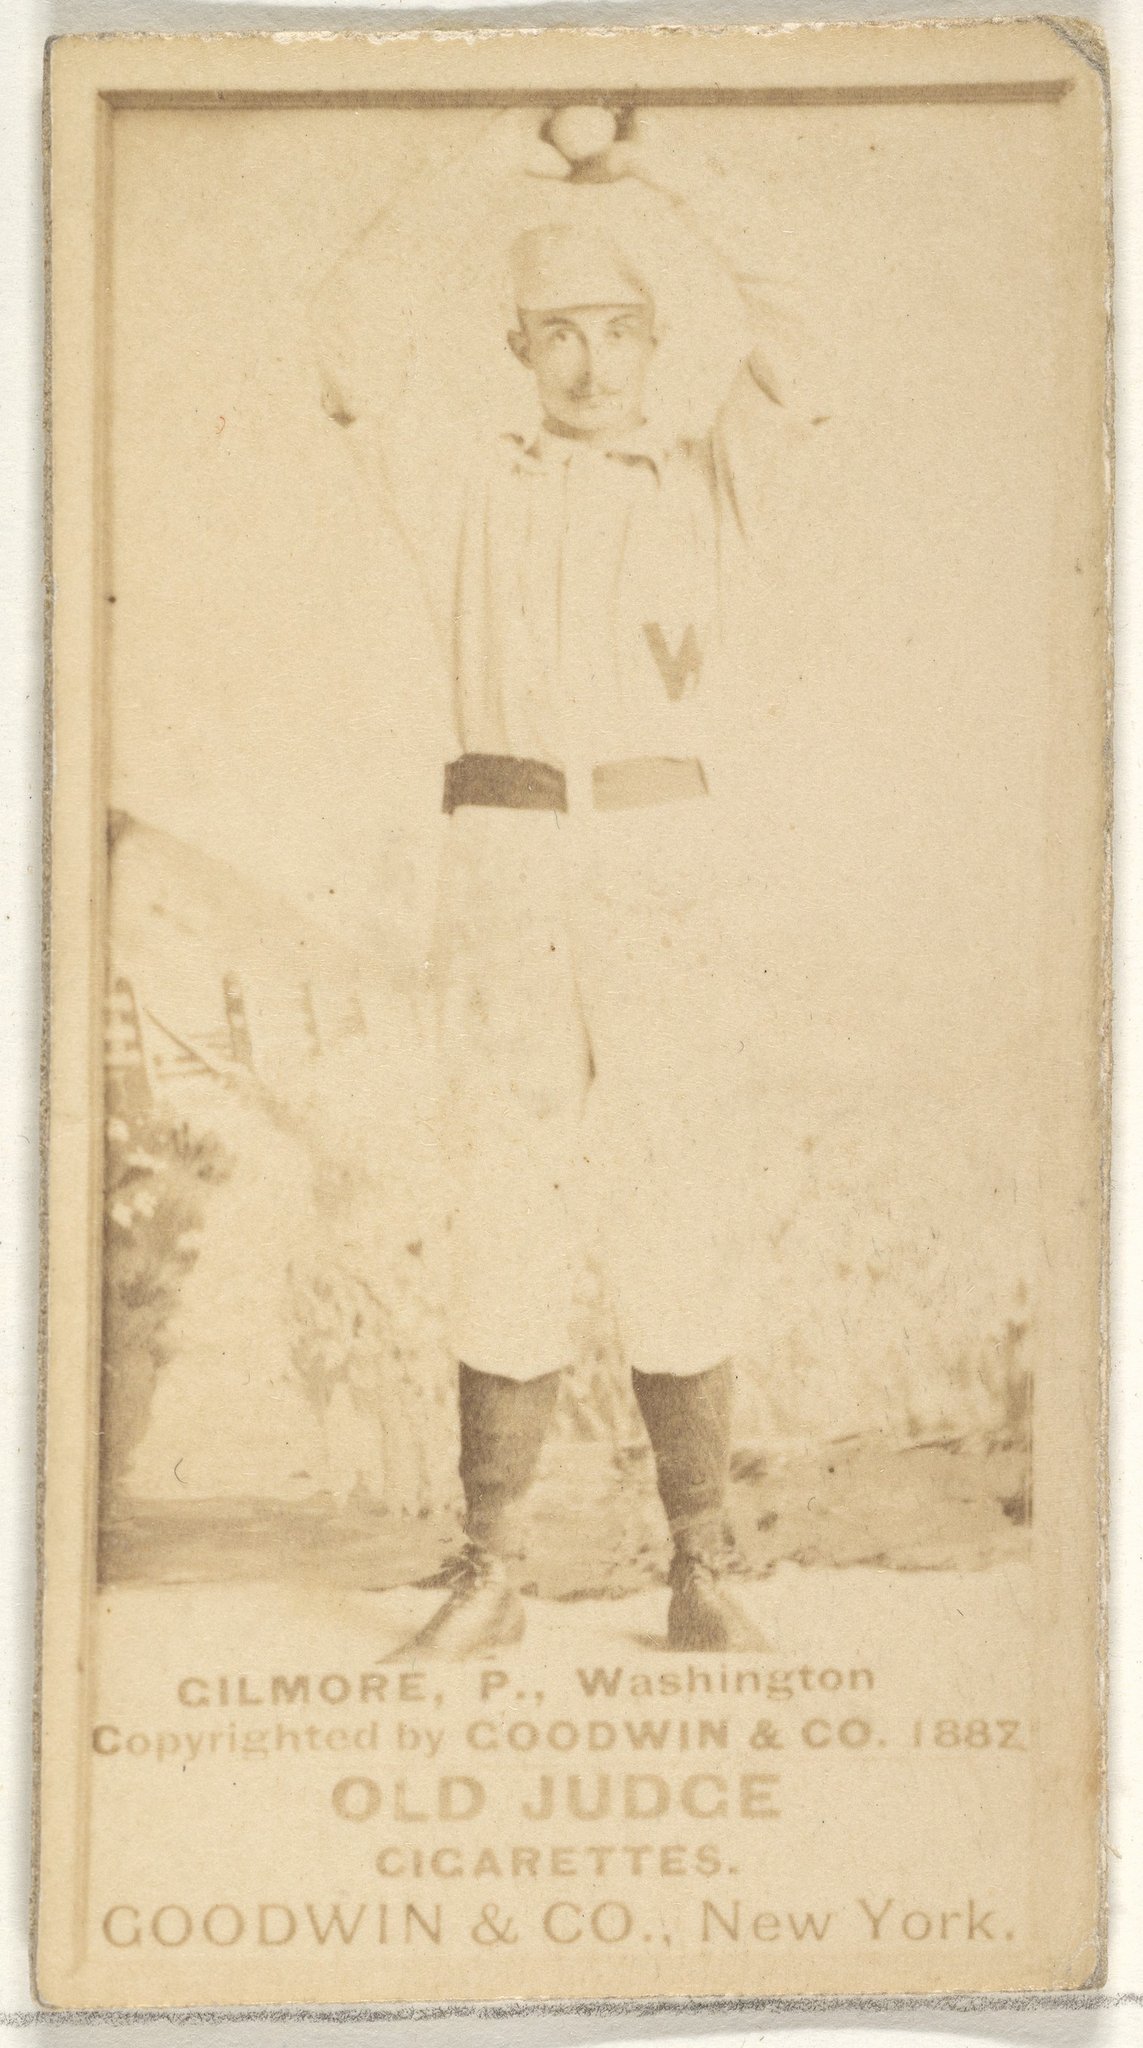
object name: baseball card, photograph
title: Frank T. Gilmore, Pitcher, Washington Nationals, from the Old Judge series (N172) for Old Judge Cigarettes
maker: goodwin & company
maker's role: publisher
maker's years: 1850-1950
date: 1887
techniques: albumen silver print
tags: men,portraits,baseball,athletes